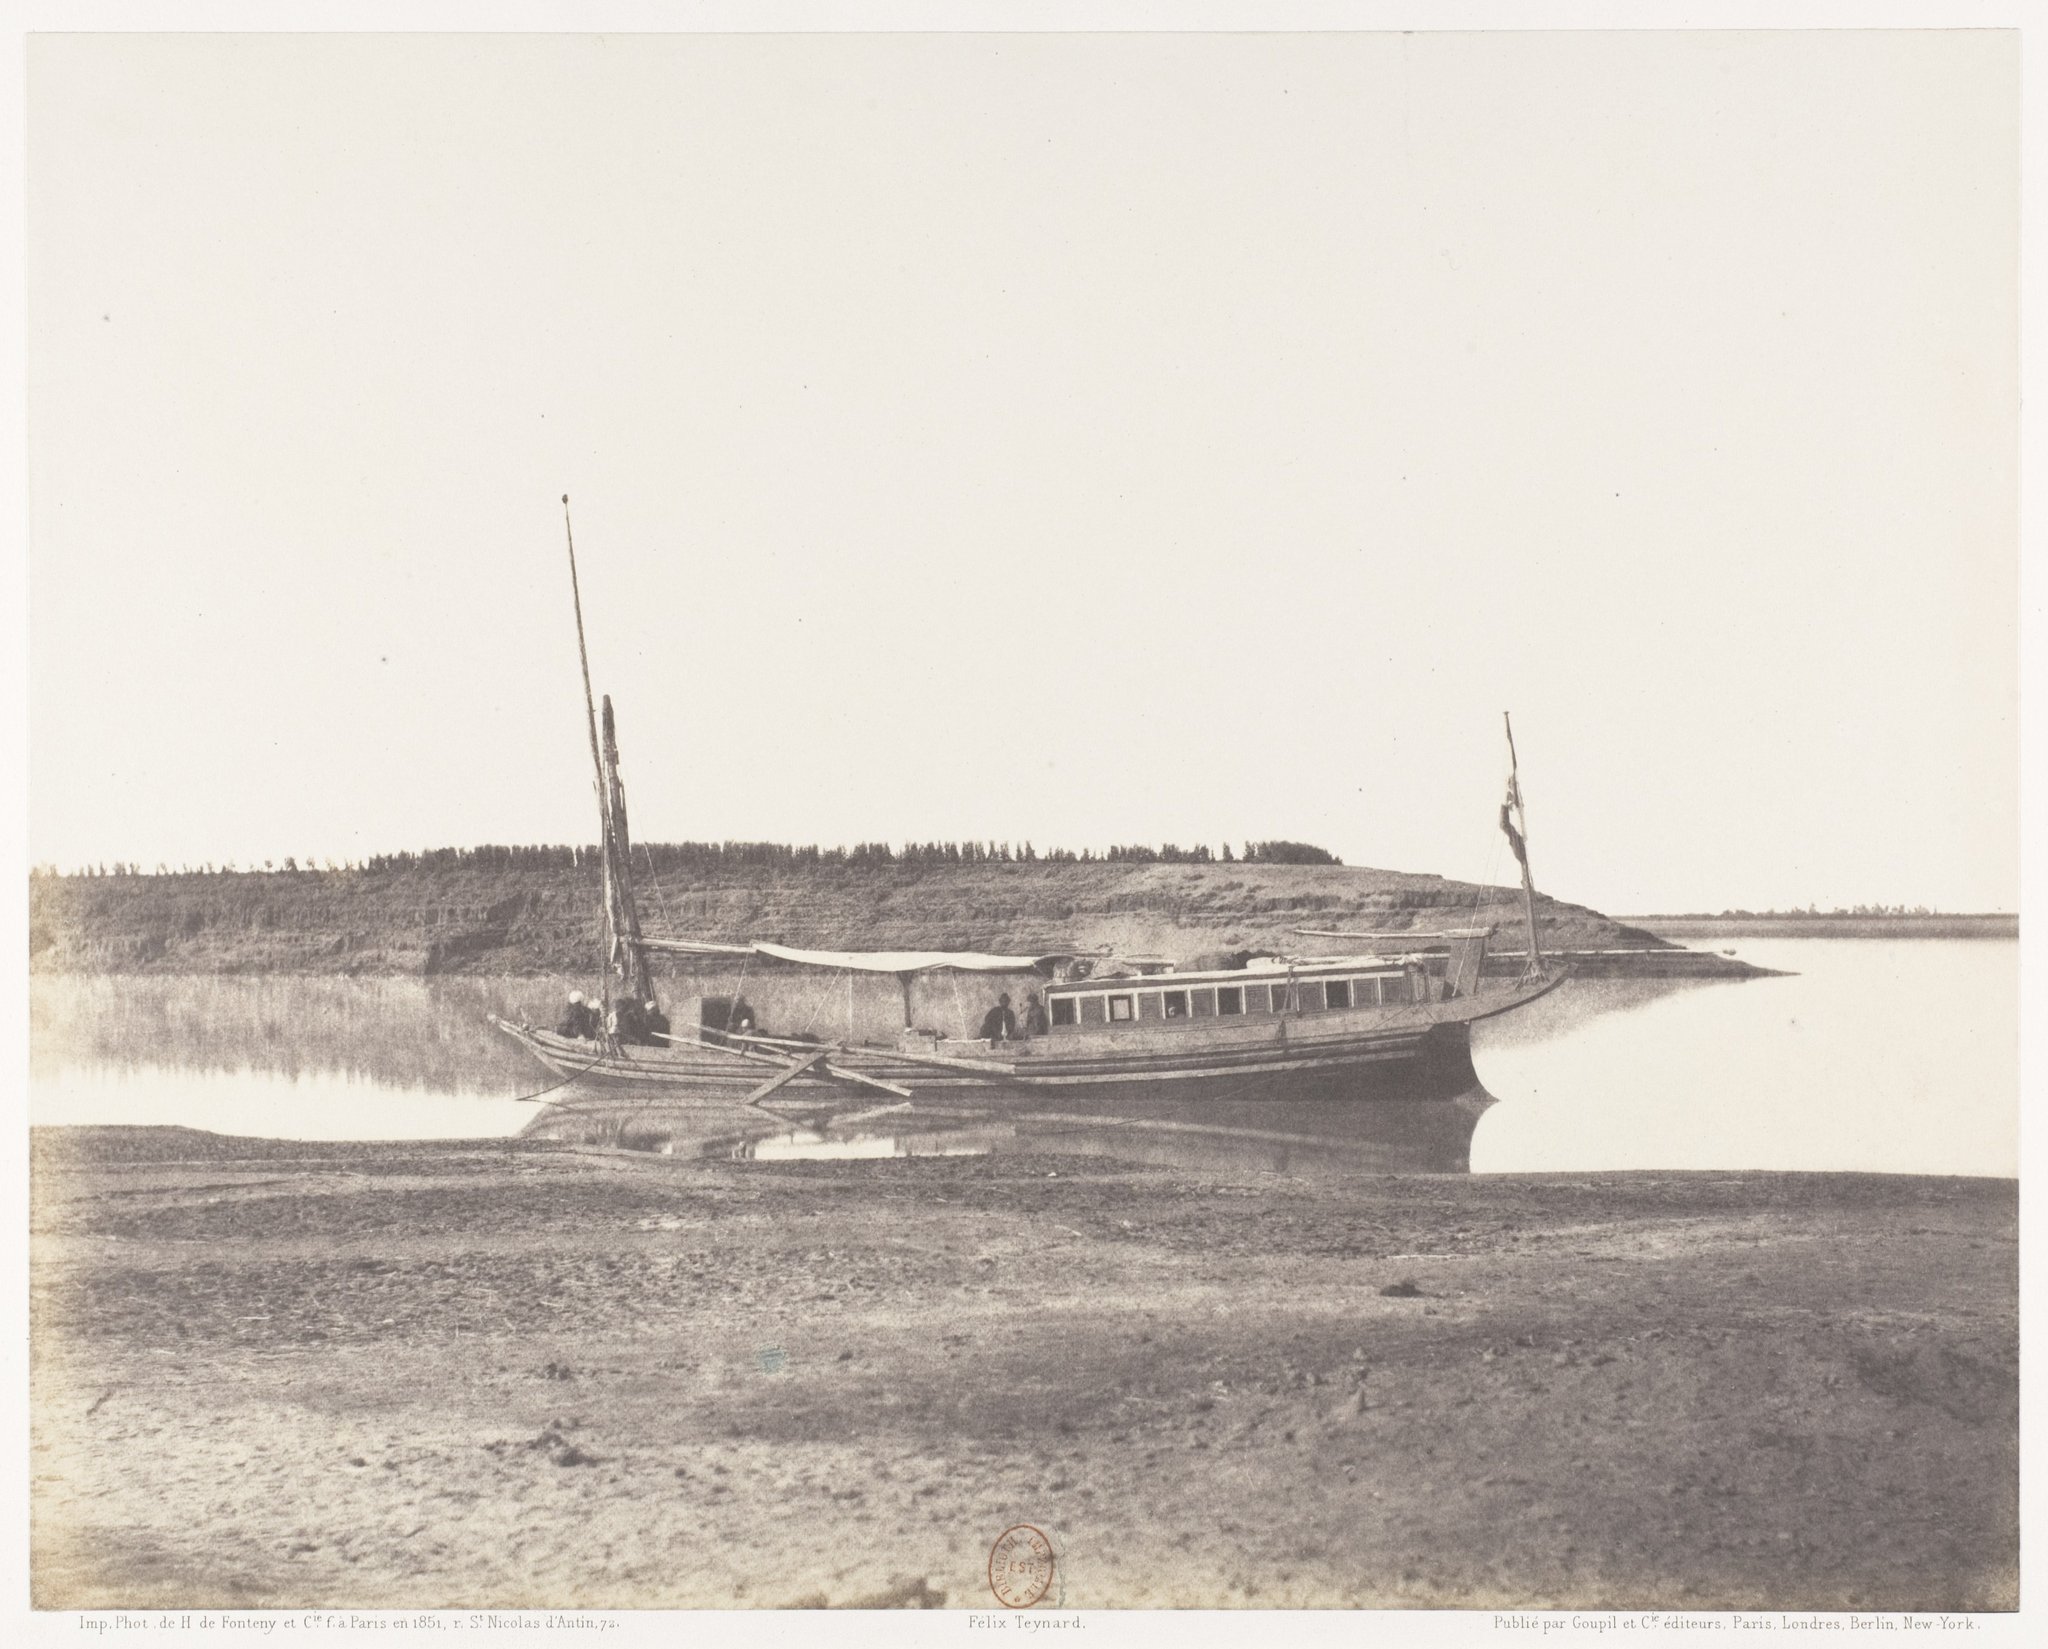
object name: photograph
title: Louksor, Petit Bras du Nil - Barque de Voyageurs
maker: félix teynard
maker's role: artist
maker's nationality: french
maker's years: 1817-1892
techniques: paper negative, salted paper print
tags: rivers,boats